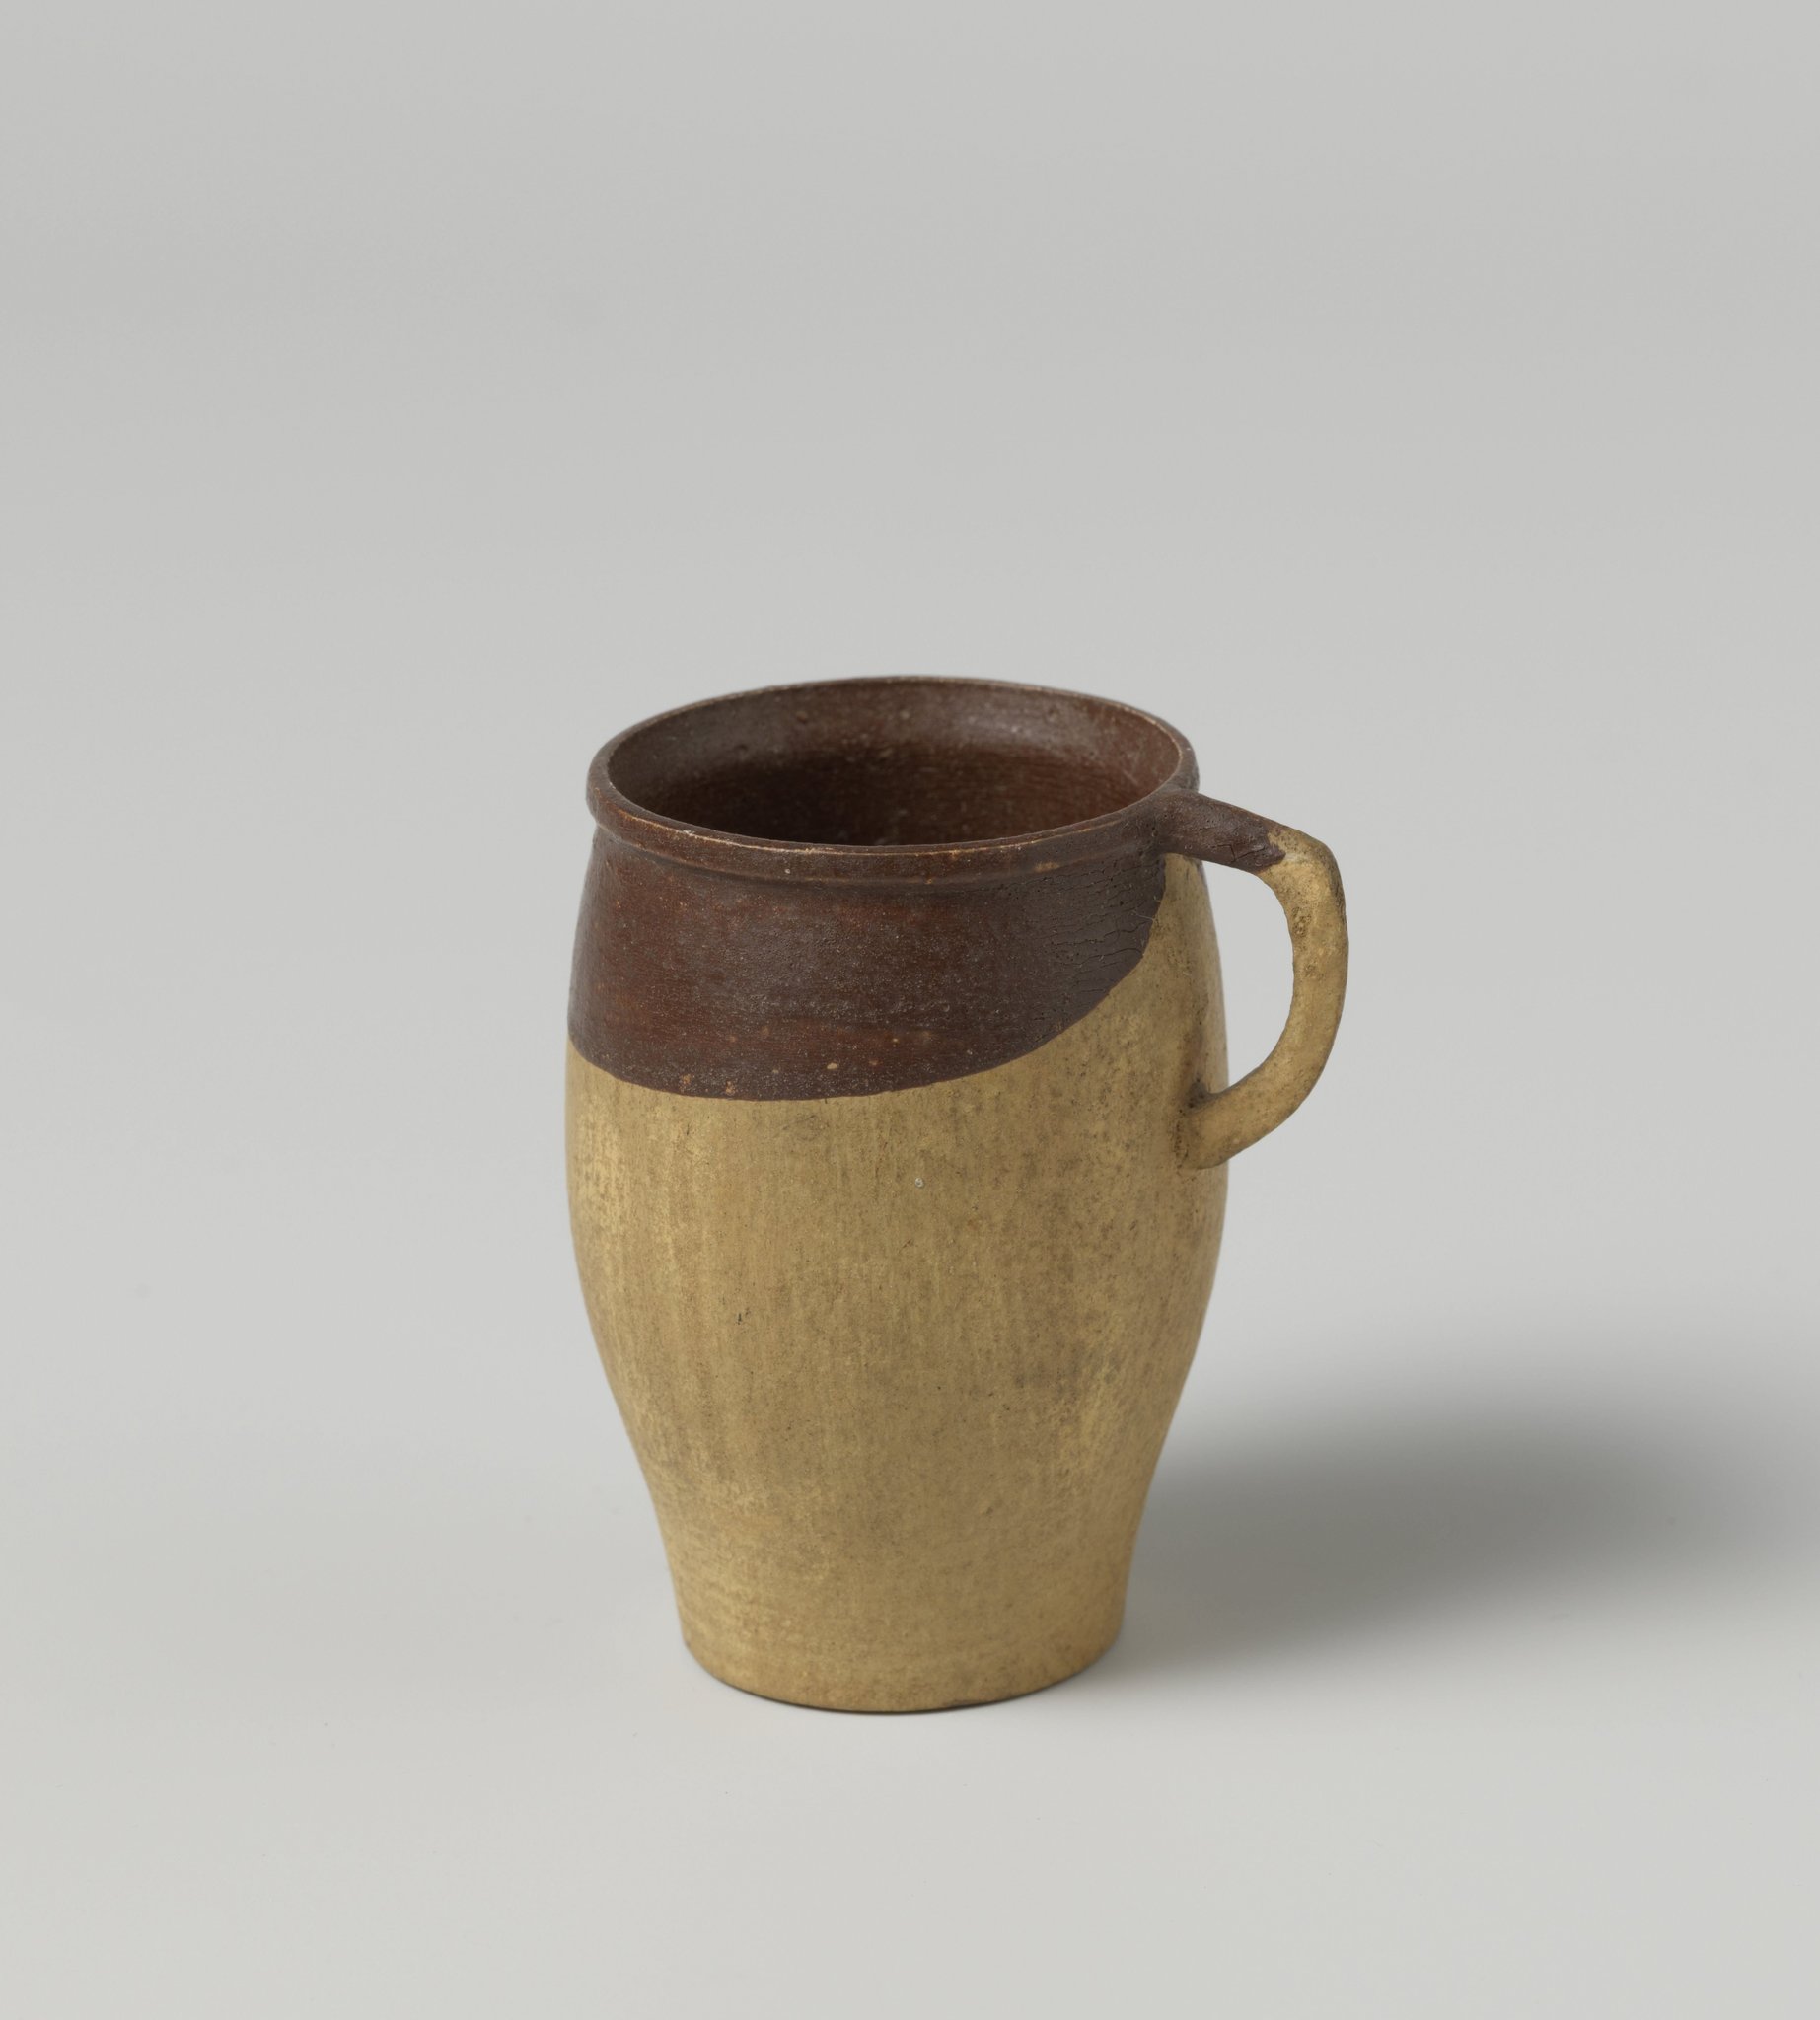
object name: storage jar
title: Voorraadpot met twee oren, beschilderd in licht- en donkerbruin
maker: Anonymous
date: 1700-1799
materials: wood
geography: amsterdam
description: Voorraadpot met twee oren van gedraaid hout; aan binnenzijde en bovenrand donkerbruin en verder lichtbruin geschilderd. Uit één stuk gedraaid.